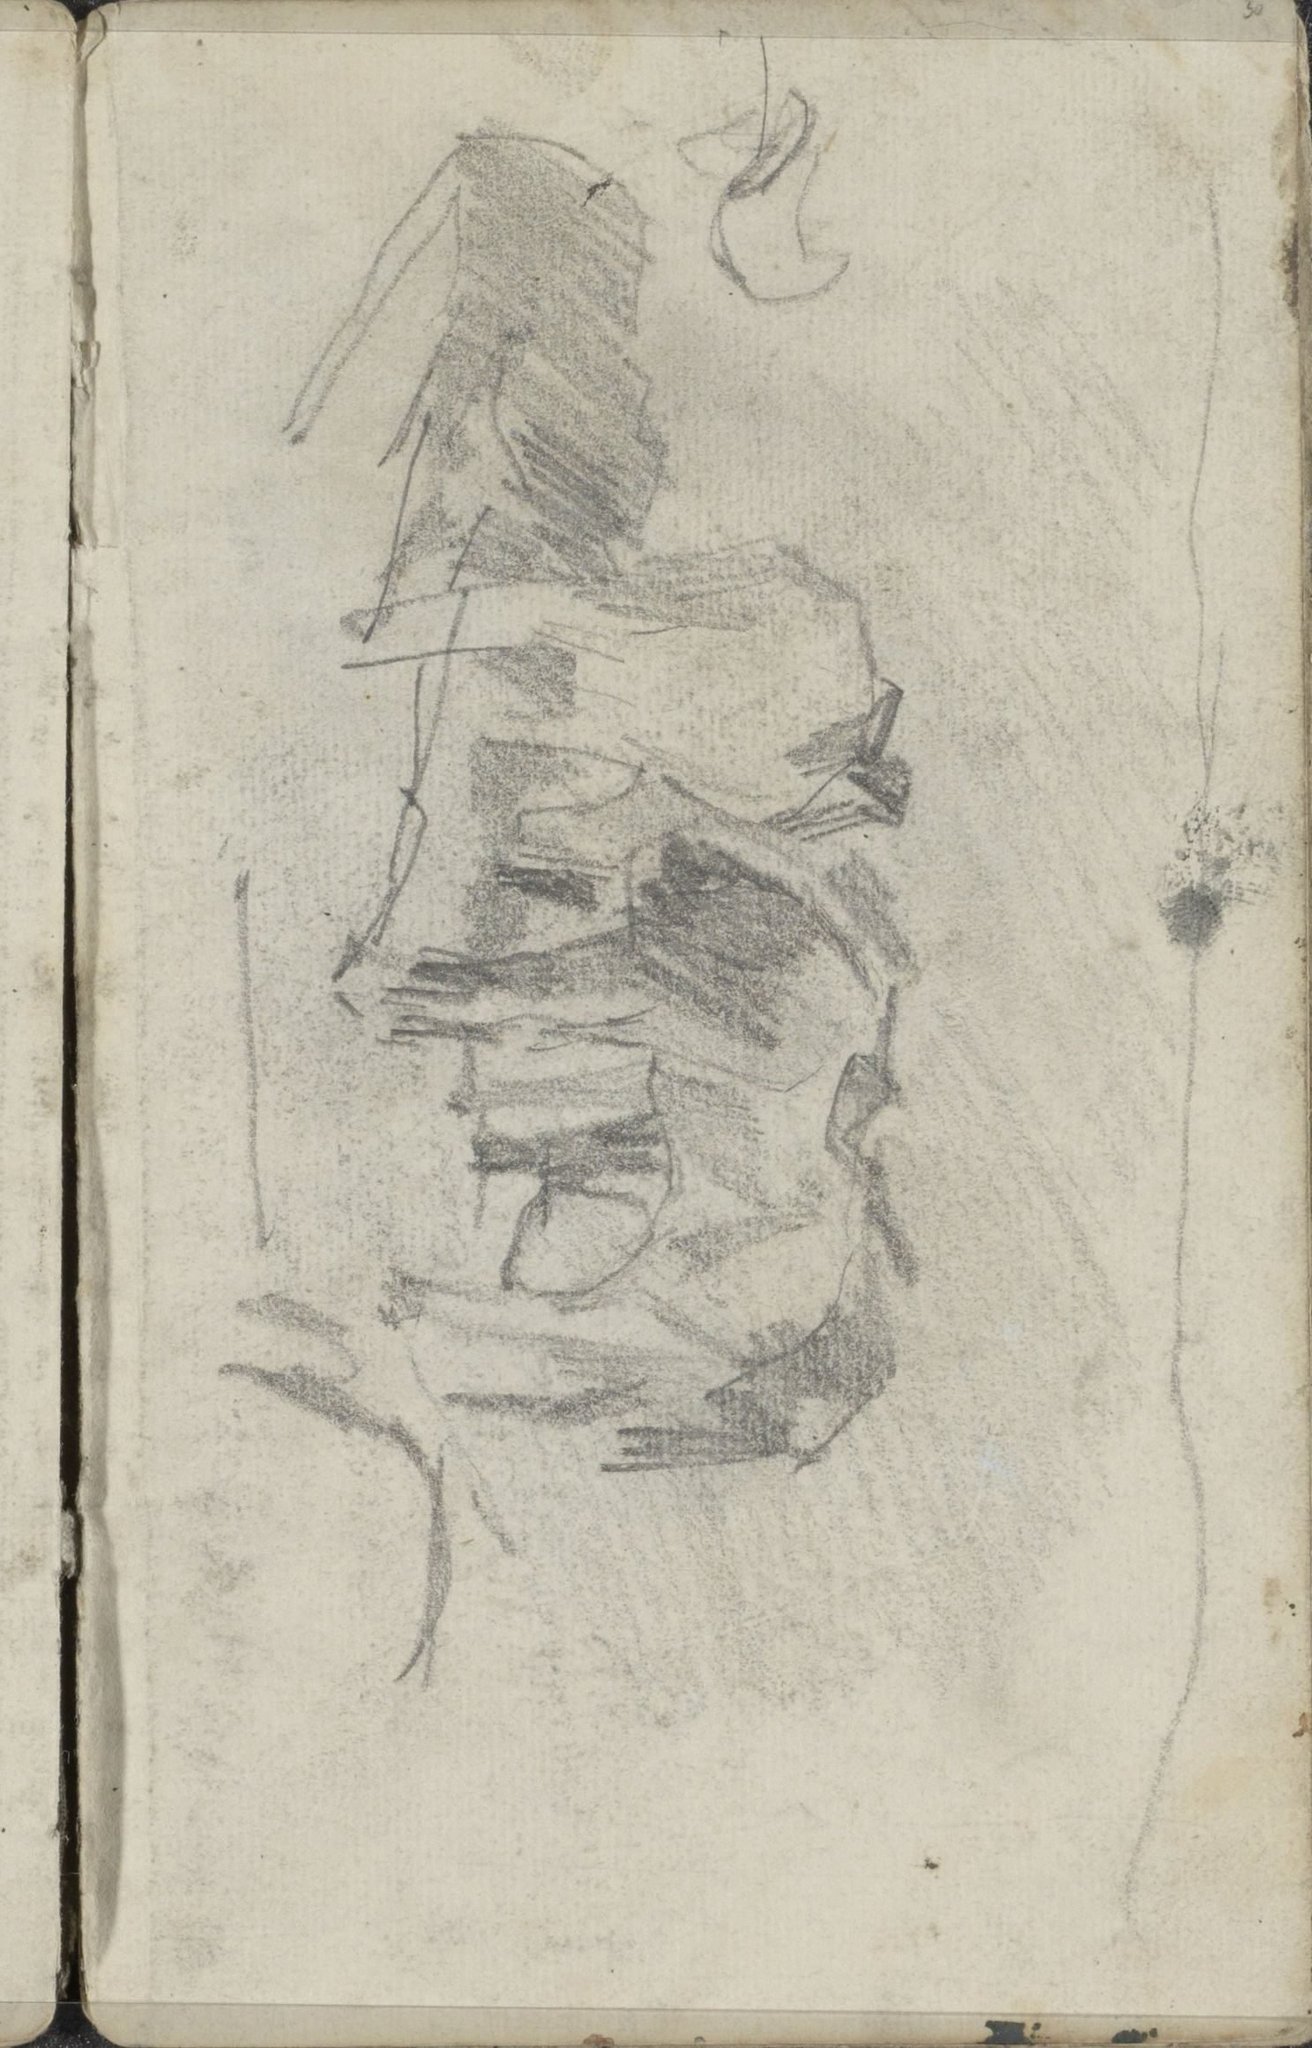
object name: sketchbook leaf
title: Grazende paarden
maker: george hendrik breitner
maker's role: draughtsman, painter, print maker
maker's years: 1857-1923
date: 1881-1883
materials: paper, pencil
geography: the hague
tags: horse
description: Pagina 50 uit een schetsboek met 27 bladen